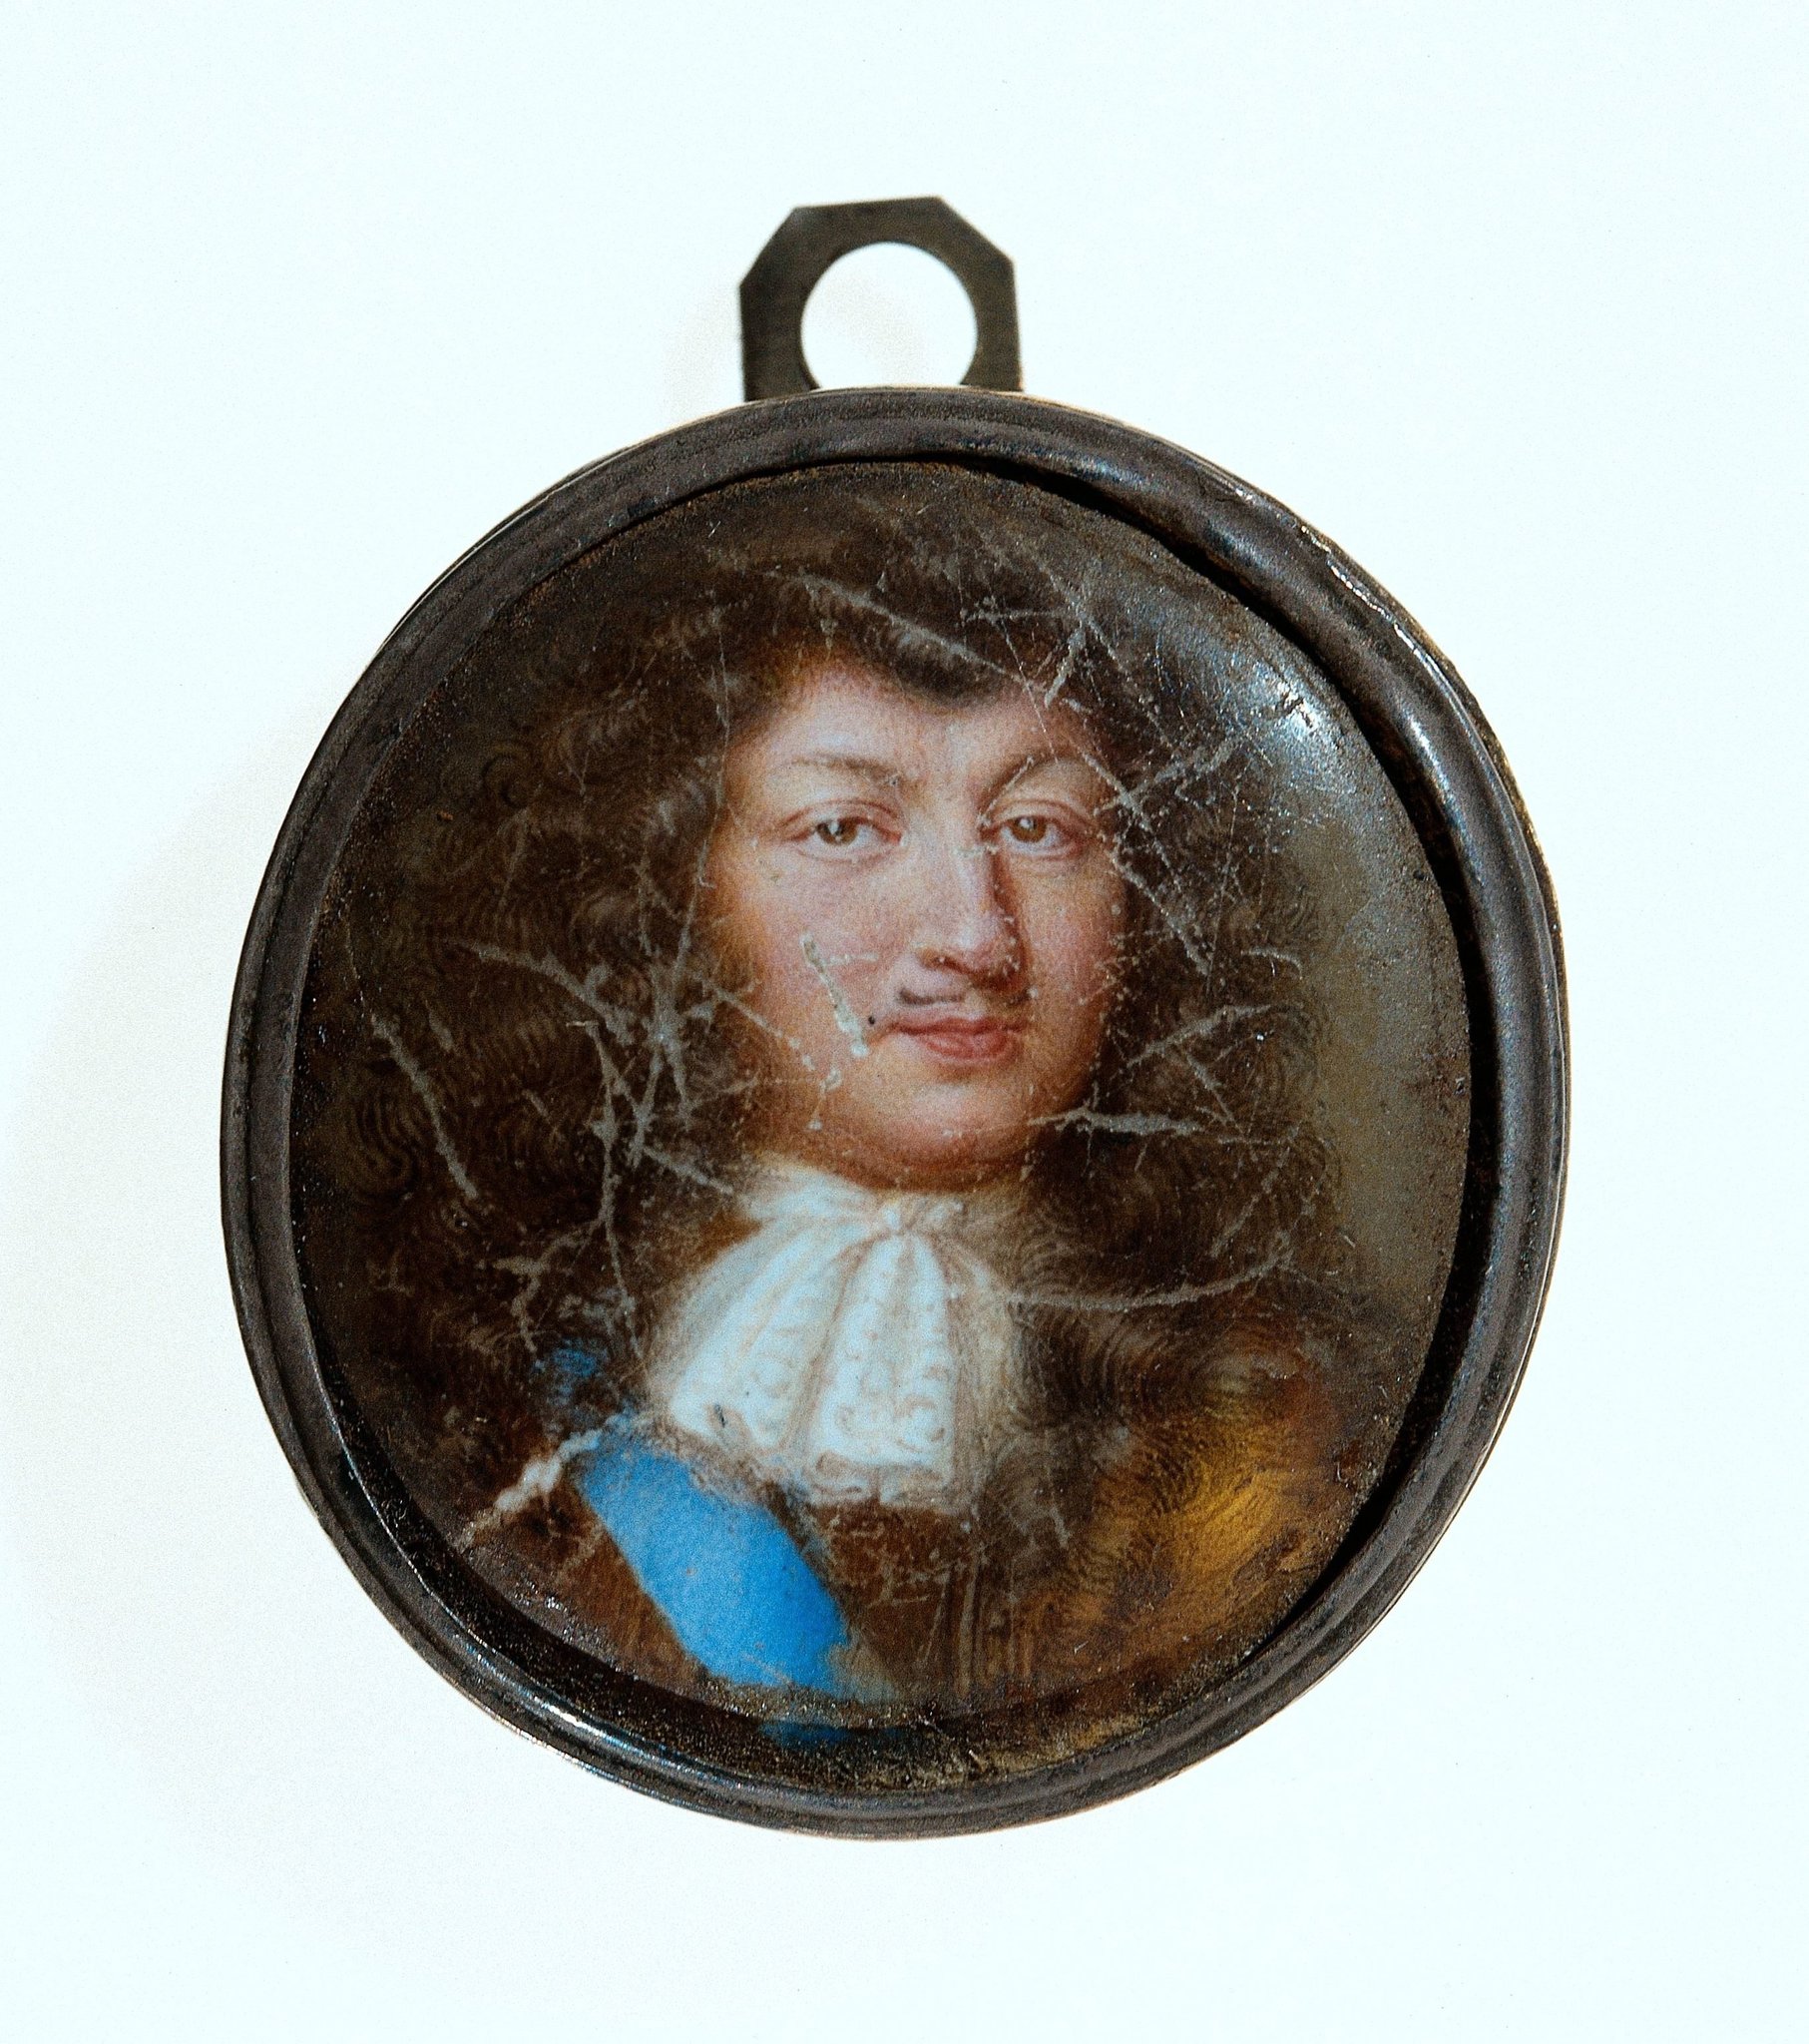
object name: painting, miniature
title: Lodewijk XIV (1638-1715), koning van Frankrijk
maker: jean petitot (le vieux)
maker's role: miniatuurschilder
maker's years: 1607-1691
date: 1665-1675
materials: copper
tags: lodewijk xiv (koning van frankrijk), historical persons, king, france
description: Medallion with portrait of Louis XIV. Enamel on copper, 17th century.